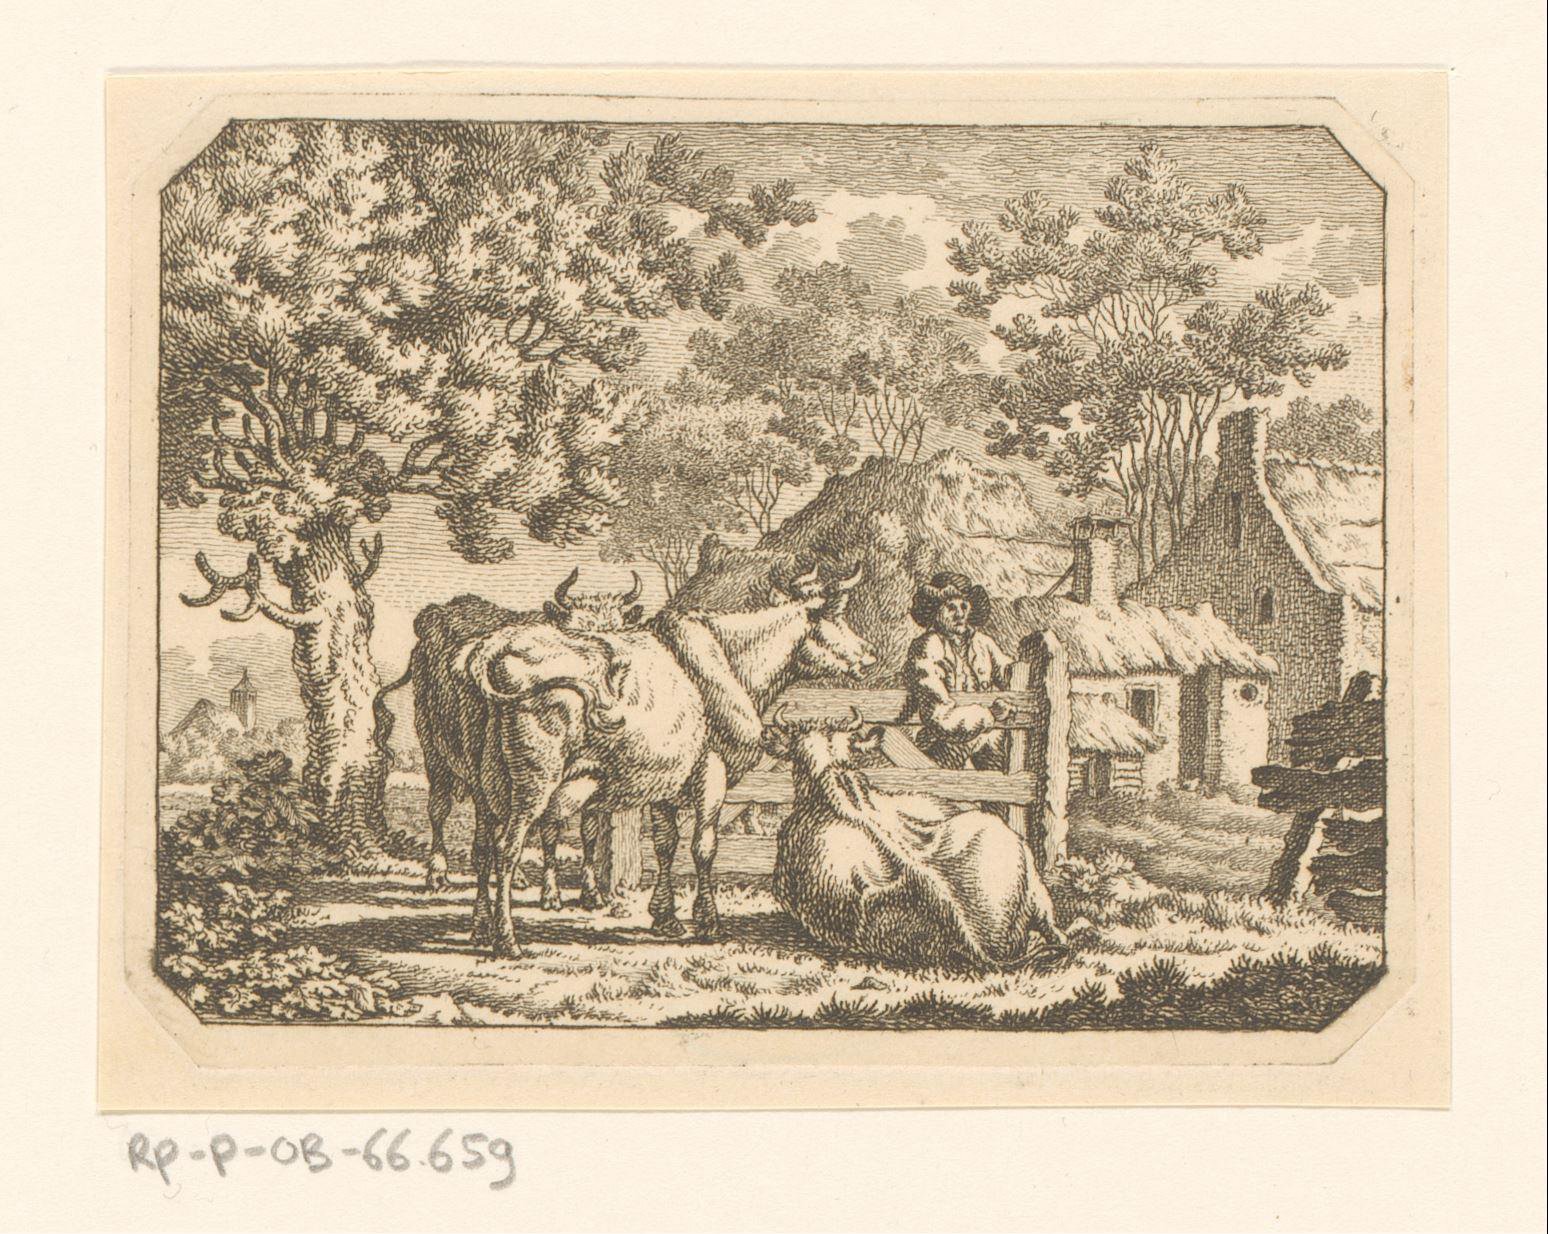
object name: print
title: Drie koeien bij een boer aan een hek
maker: jacob elias van varelen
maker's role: draughtsman, print maker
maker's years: 1757-1840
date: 1818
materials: paper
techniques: etching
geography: haarlem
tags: cow, farm or solitary house in landscape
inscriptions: collector's mark: Lugt 2228